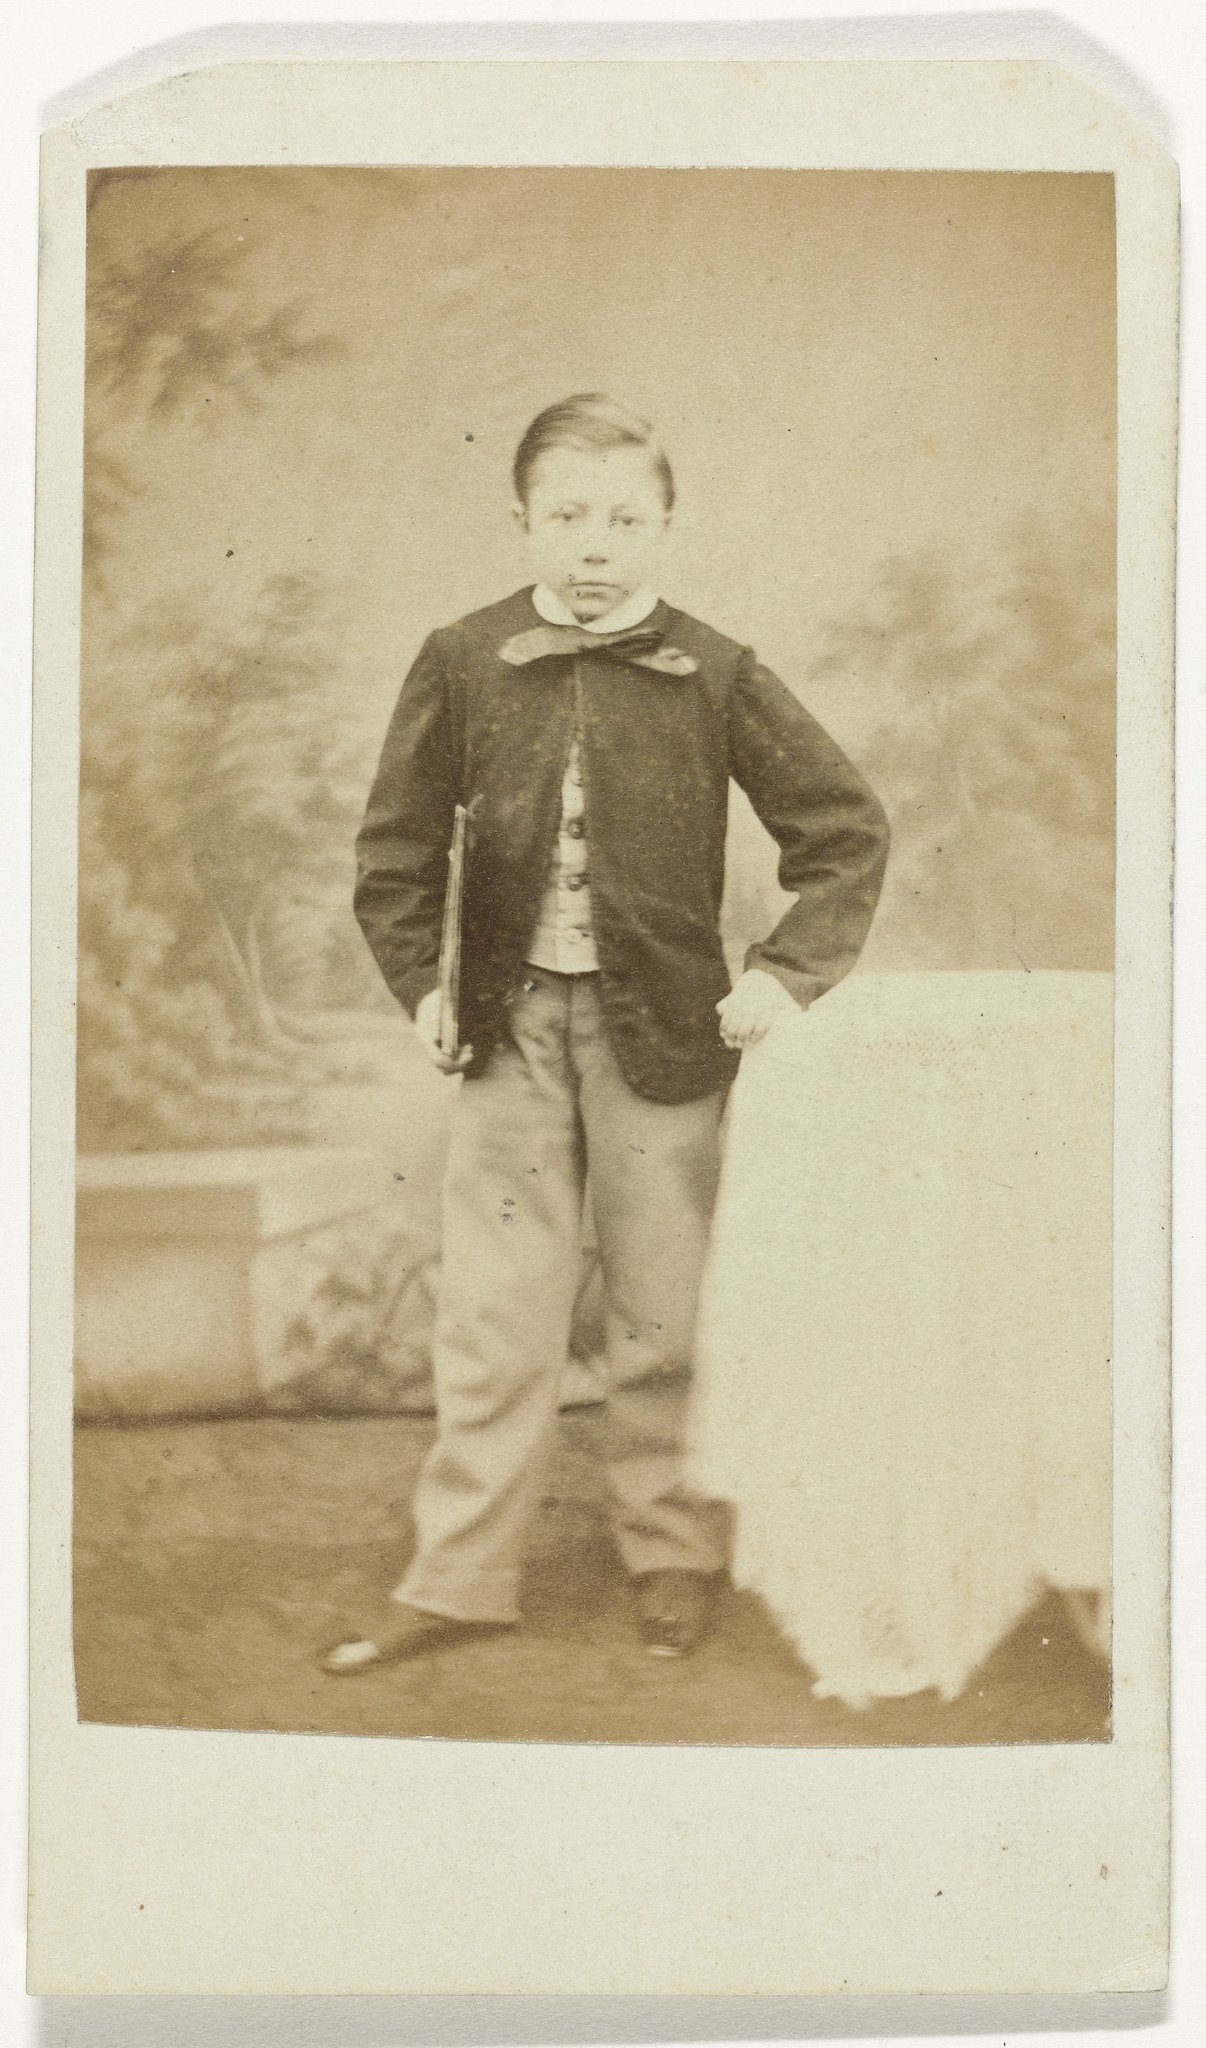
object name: photograph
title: Portret van een jongen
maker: j. wijnman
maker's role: fotograaf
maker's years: 1844-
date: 1866-1870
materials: cardboard, paper, photographic support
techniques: albumen print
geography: amsterdam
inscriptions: address: ‘PHOTOGRAFISCH ATELIER // van // J. WIJNMAN // Halsteeg No. 248 // AMSTERDAM’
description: Portret van een jongen, staande naast een tafel met een licht kleed erover, voor een geschilderde achtergrond.